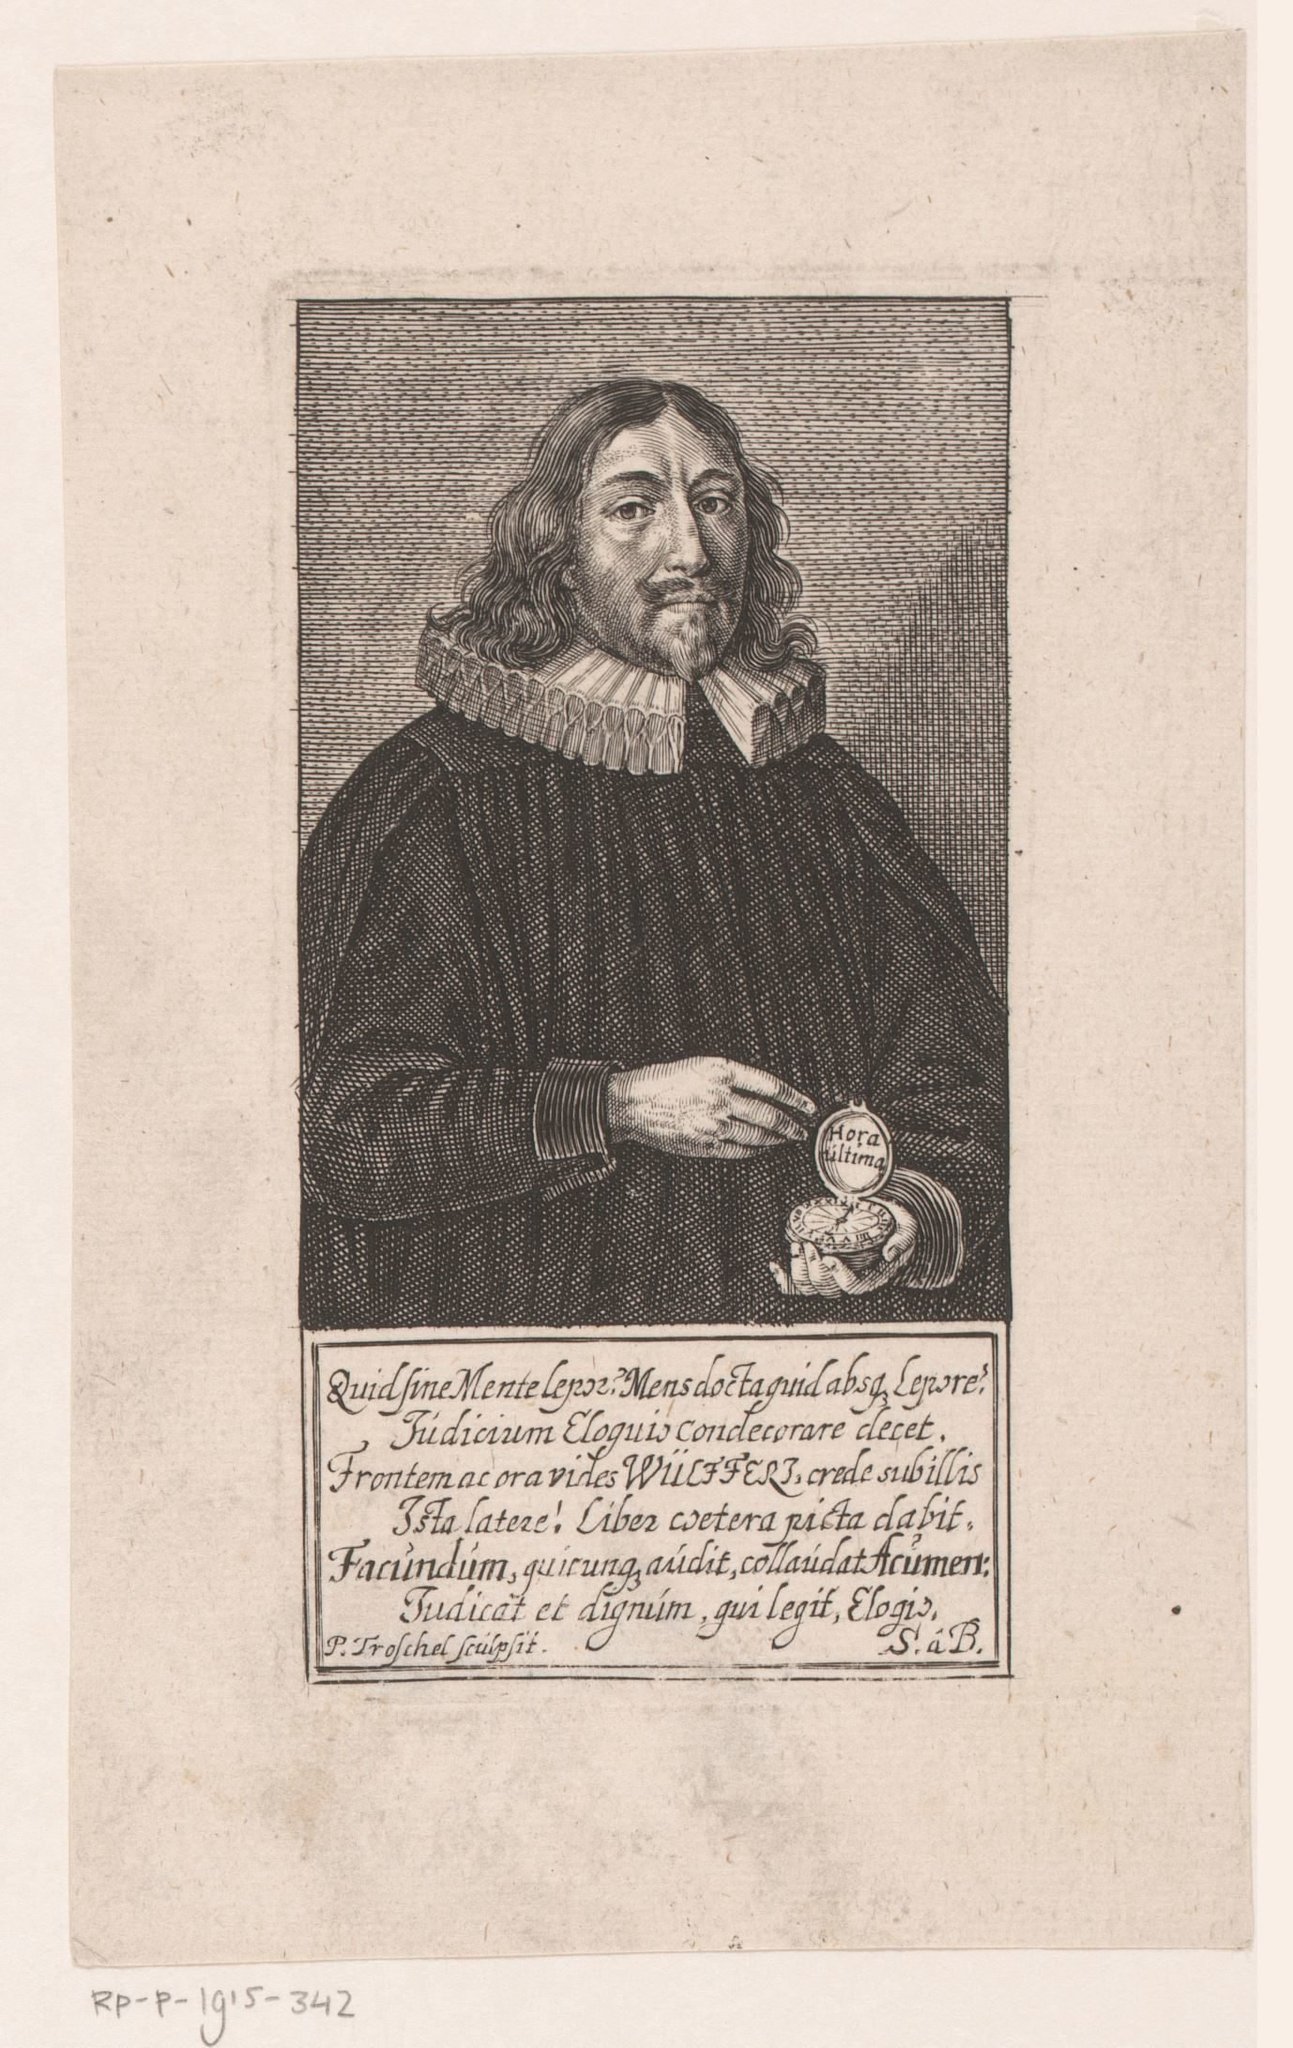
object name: print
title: Portret van Daniel Wülfer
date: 1650-1670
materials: paper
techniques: engraving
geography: germany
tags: daniel wülfer, historical persons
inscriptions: collector's mark: Lugt 2228